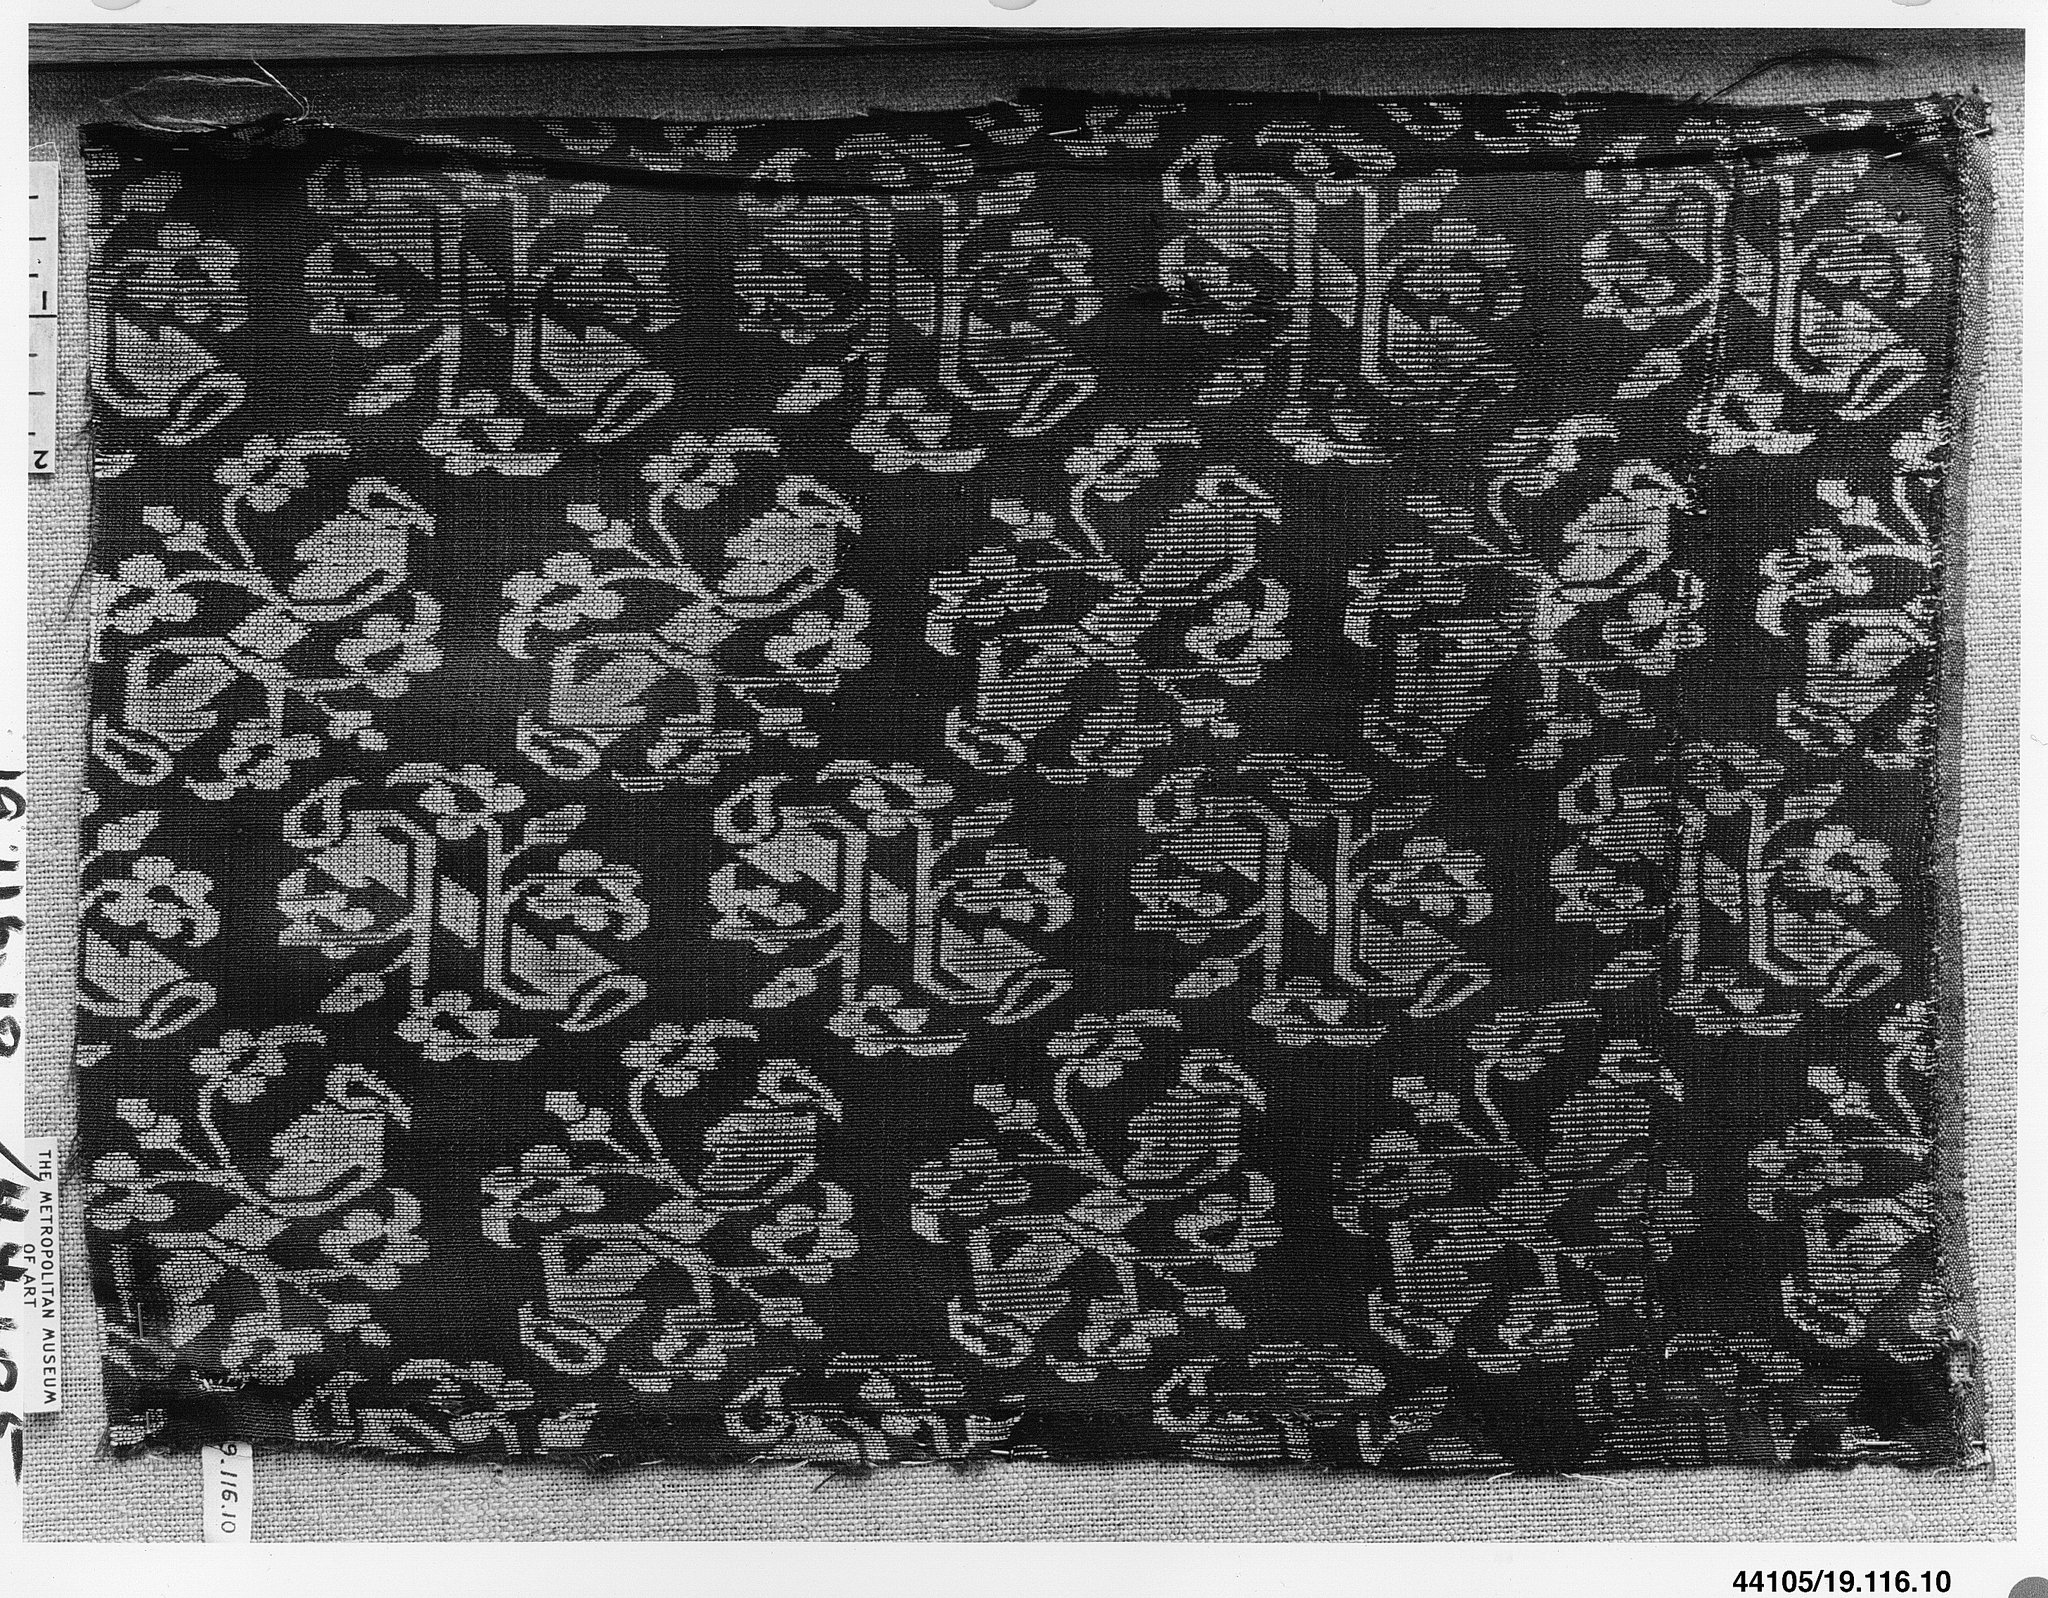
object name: piece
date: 1601-1633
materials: silk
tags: leaves